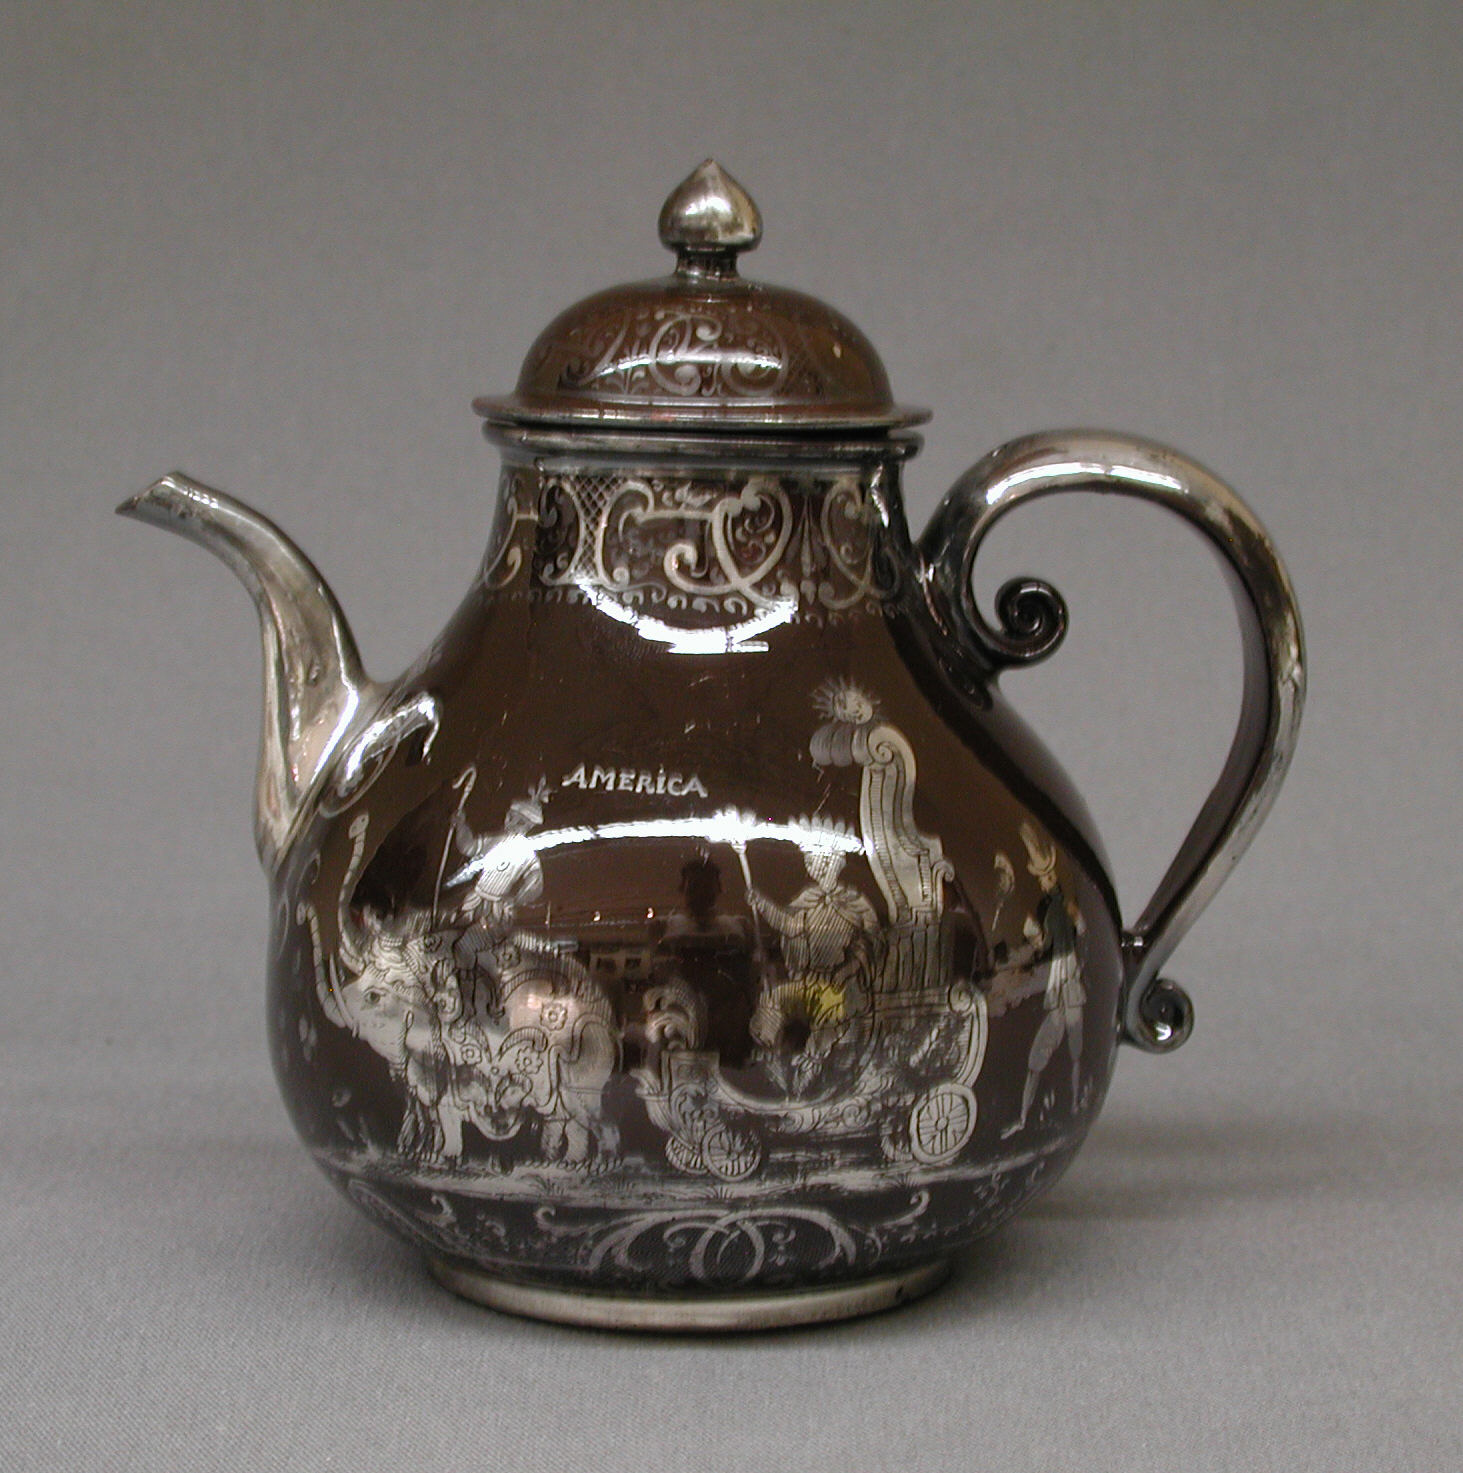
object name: teapot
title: Teapot (part of a set)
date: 1726-1750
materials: earthenware, silver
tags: birds,men,carriages